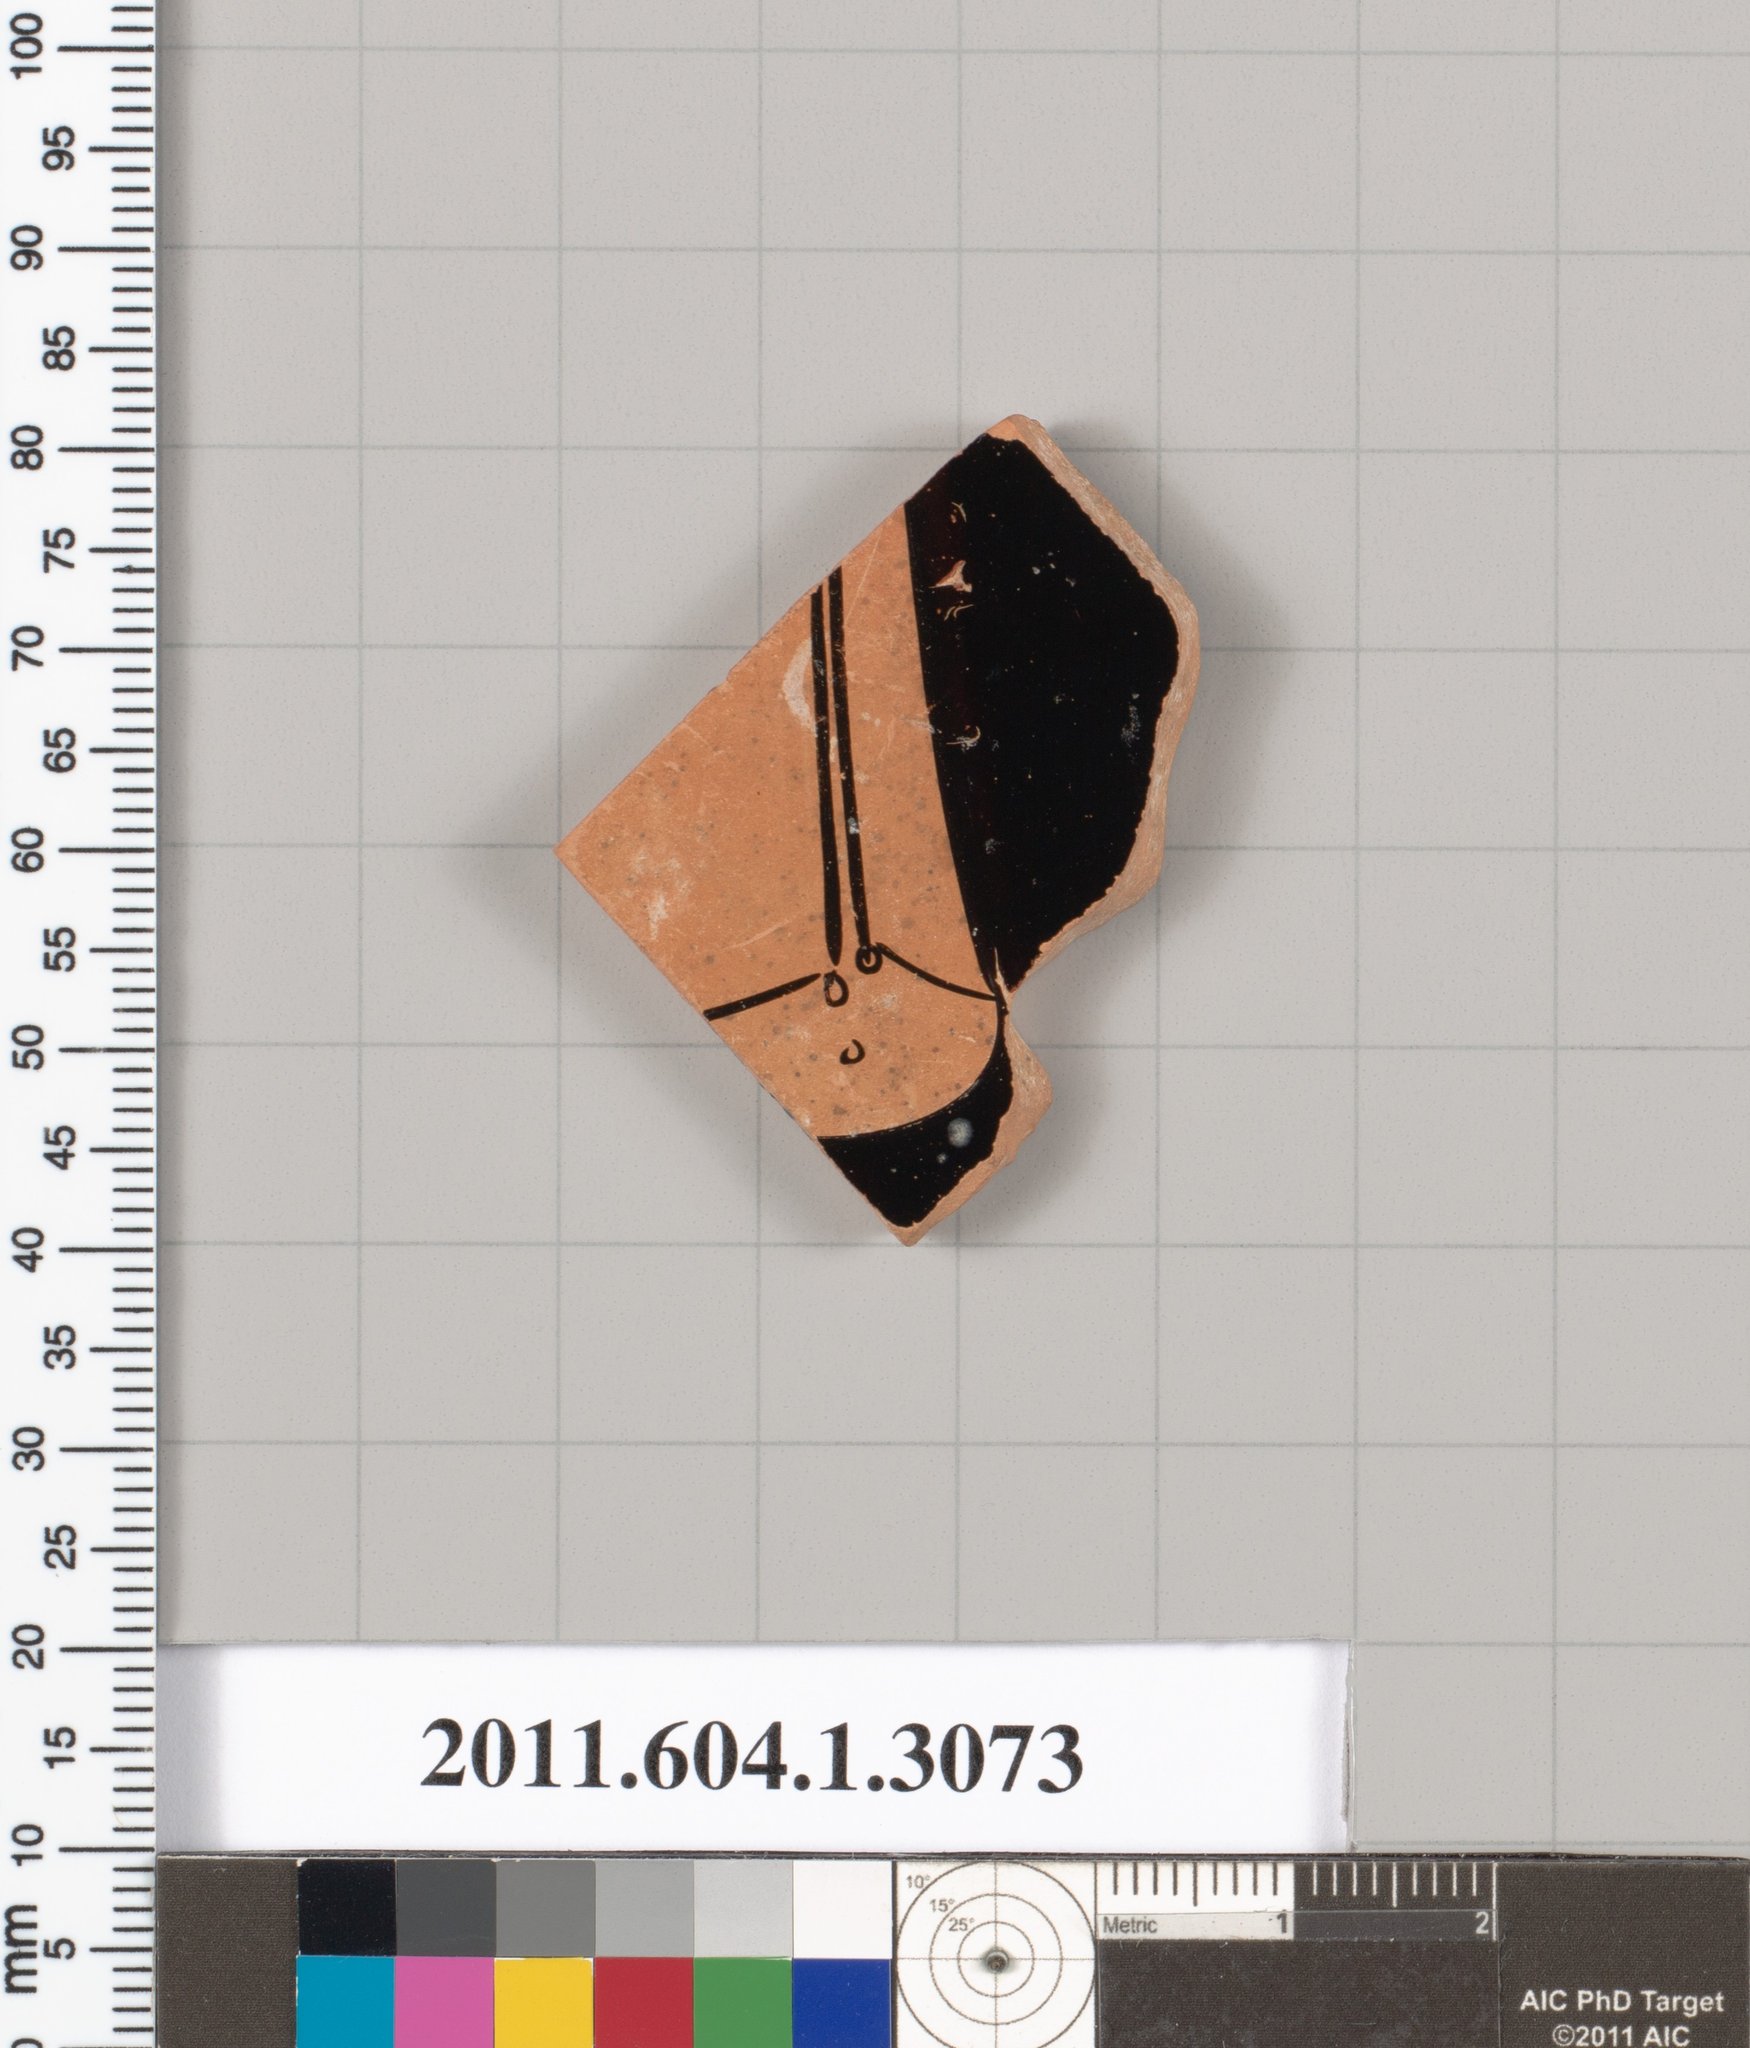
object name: kylix fragment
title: Terracotta fragment of a kylix (drinking cup)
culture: greek, attic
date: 500-490 BCE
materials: terracotta